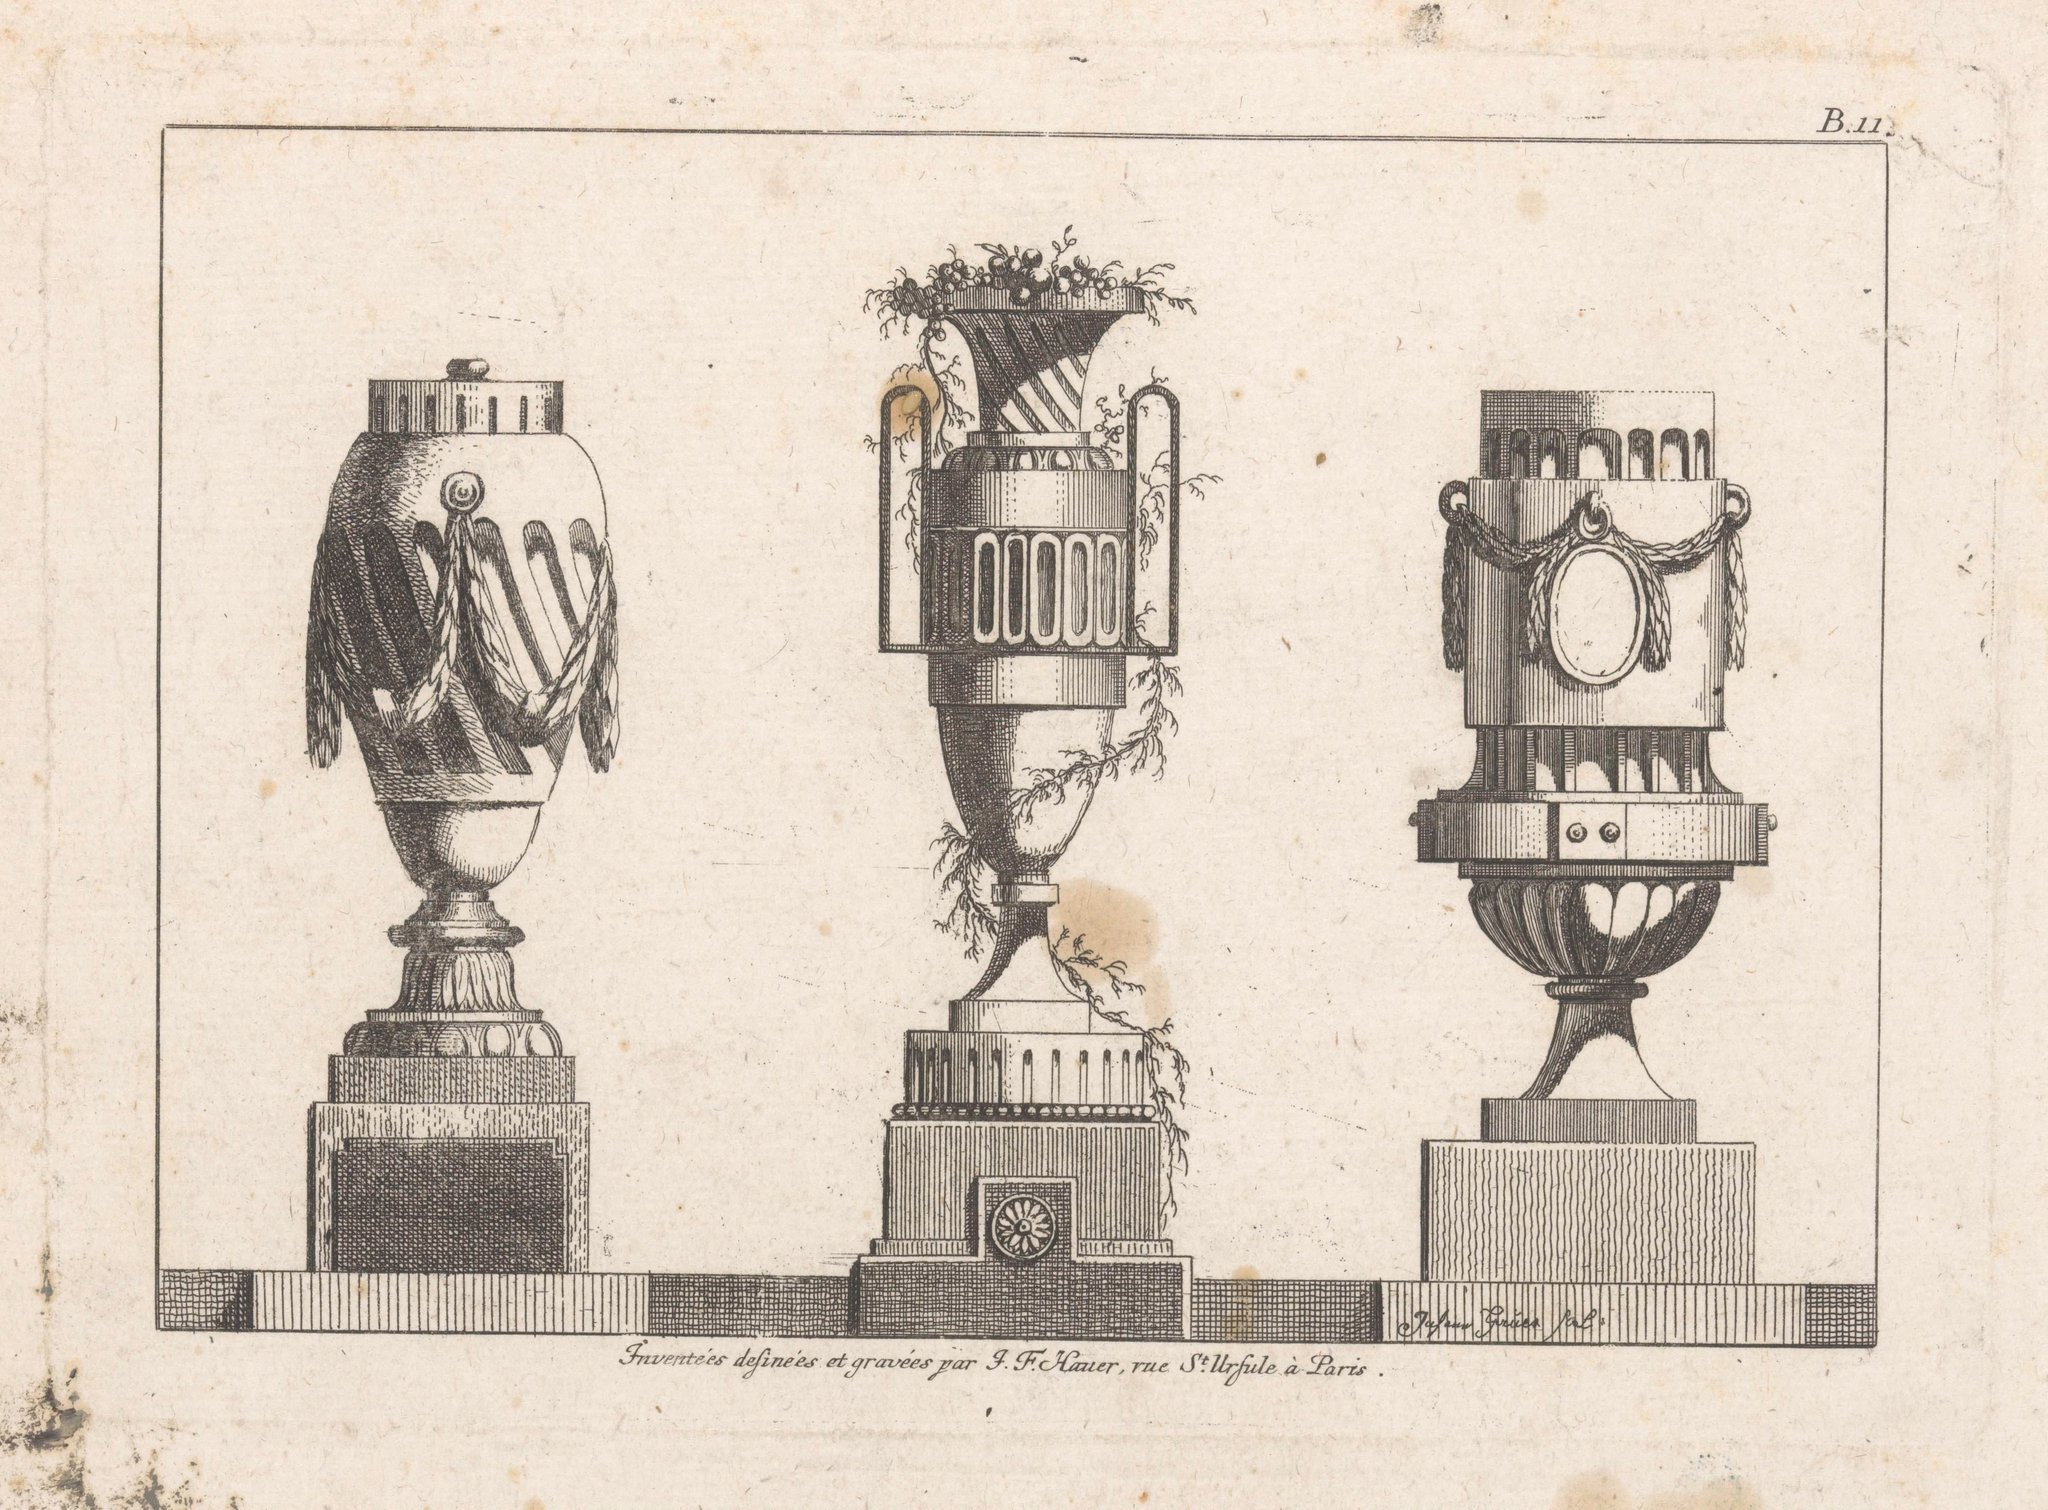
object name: print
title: Desseins de la Mode neuve au Gout antique (...)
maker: johann thomas hauer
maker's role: print maker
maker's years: 1748-1820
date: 1758-1820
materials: paper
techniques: engraving, etching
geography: paris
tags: vase ~ ornament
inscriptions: collector's mark: Lugt 2228, collector's mark: Lugt 2760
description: Ontwerpen voor drie vazen op voetstuk met bloemen, fruit, guirlandes en ornamenten. De middelste vaas met twee oren.